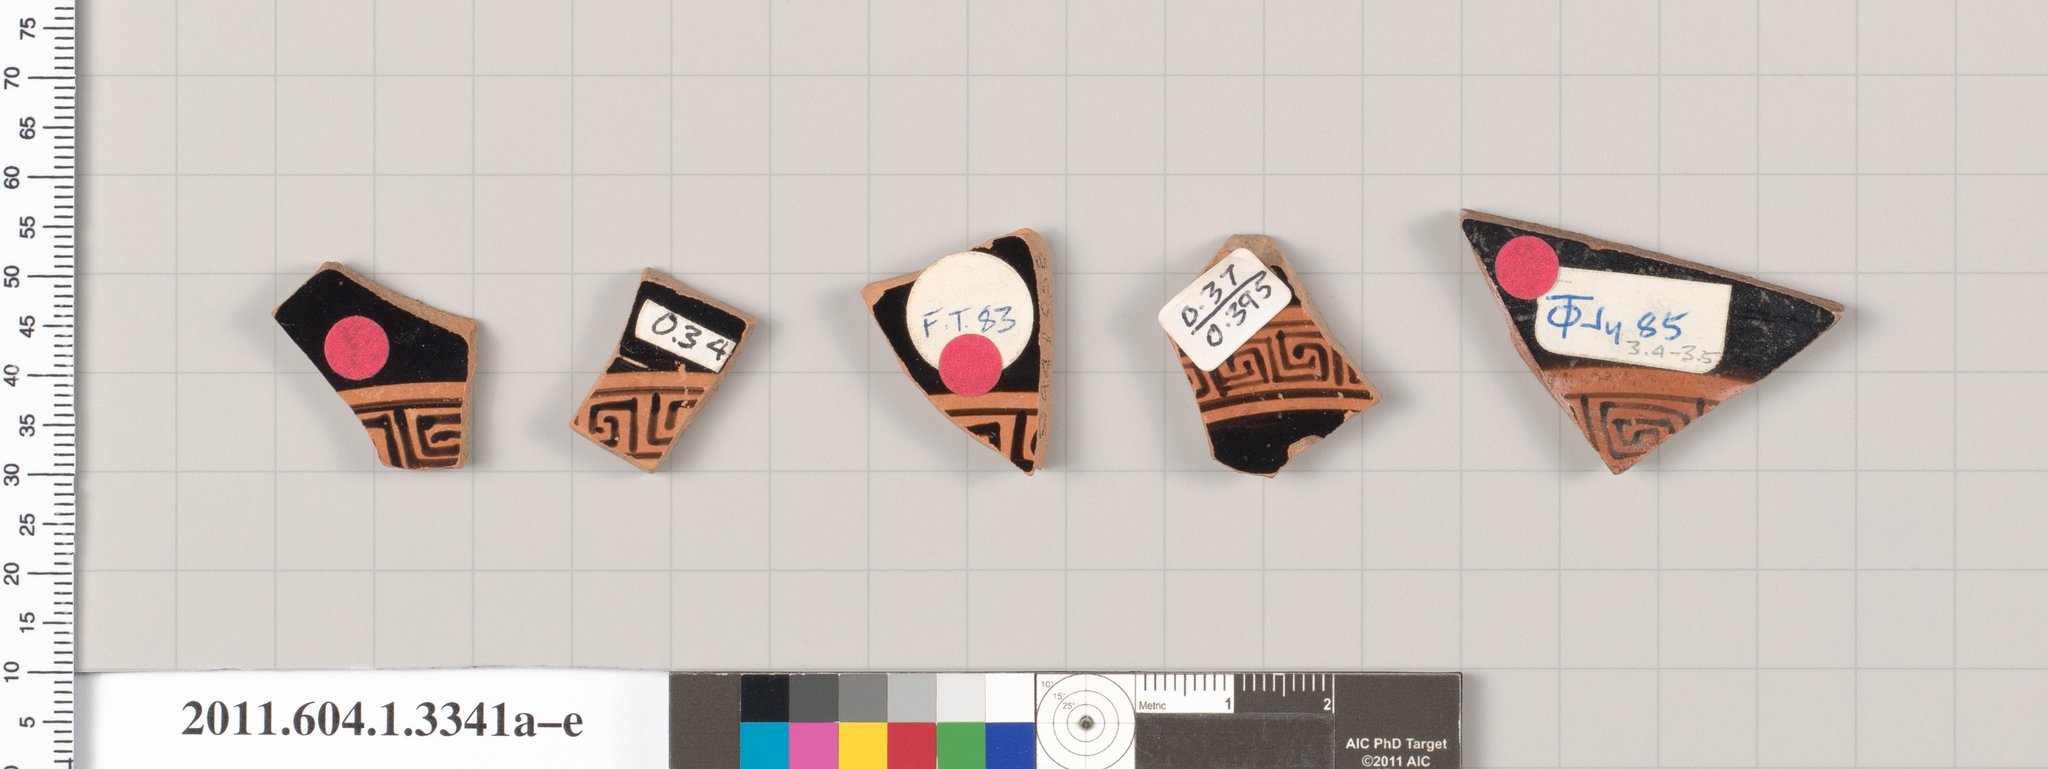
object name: kylix fragment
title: Terracotta fragments of kylikes (drinking cups)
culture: greek, attic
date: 500-470 BCE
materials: terracotta